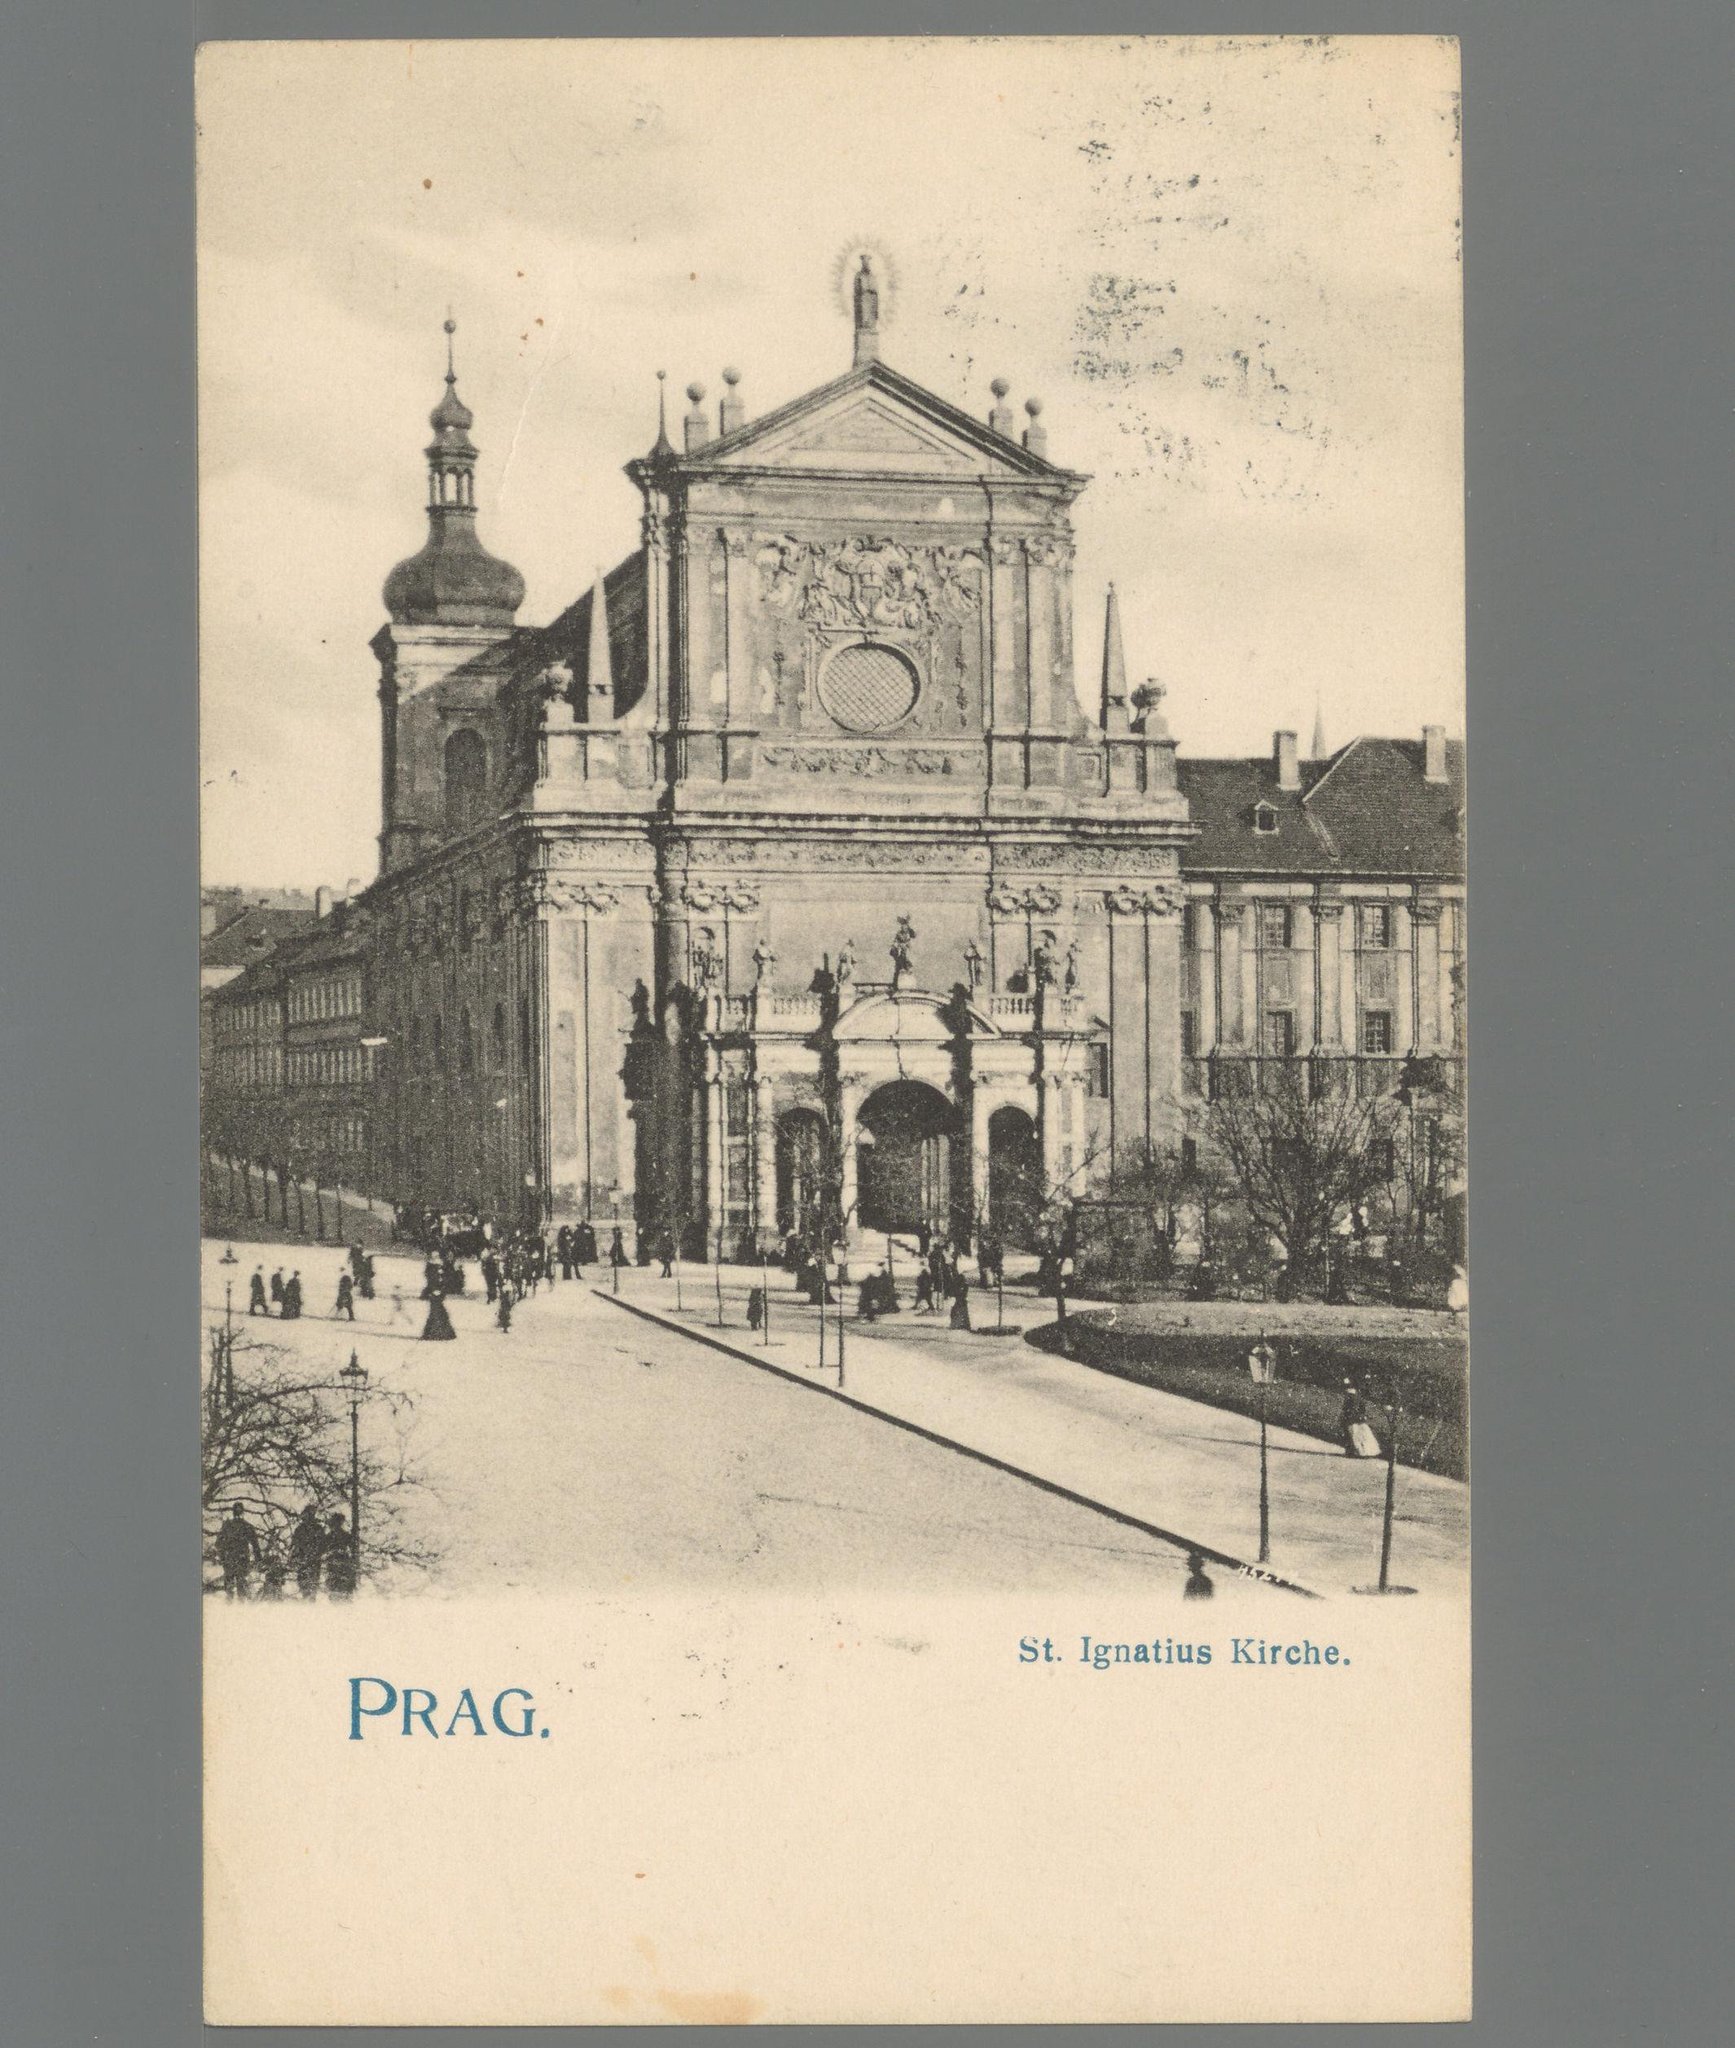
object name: ansichtkaart, prentbriefkaart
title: Prag. St. Ignatius Kirche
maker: Anonymous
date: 1900-1906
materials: cardboard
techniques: photograph, writing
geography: prague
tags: church (exterior)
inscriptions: postage stamp